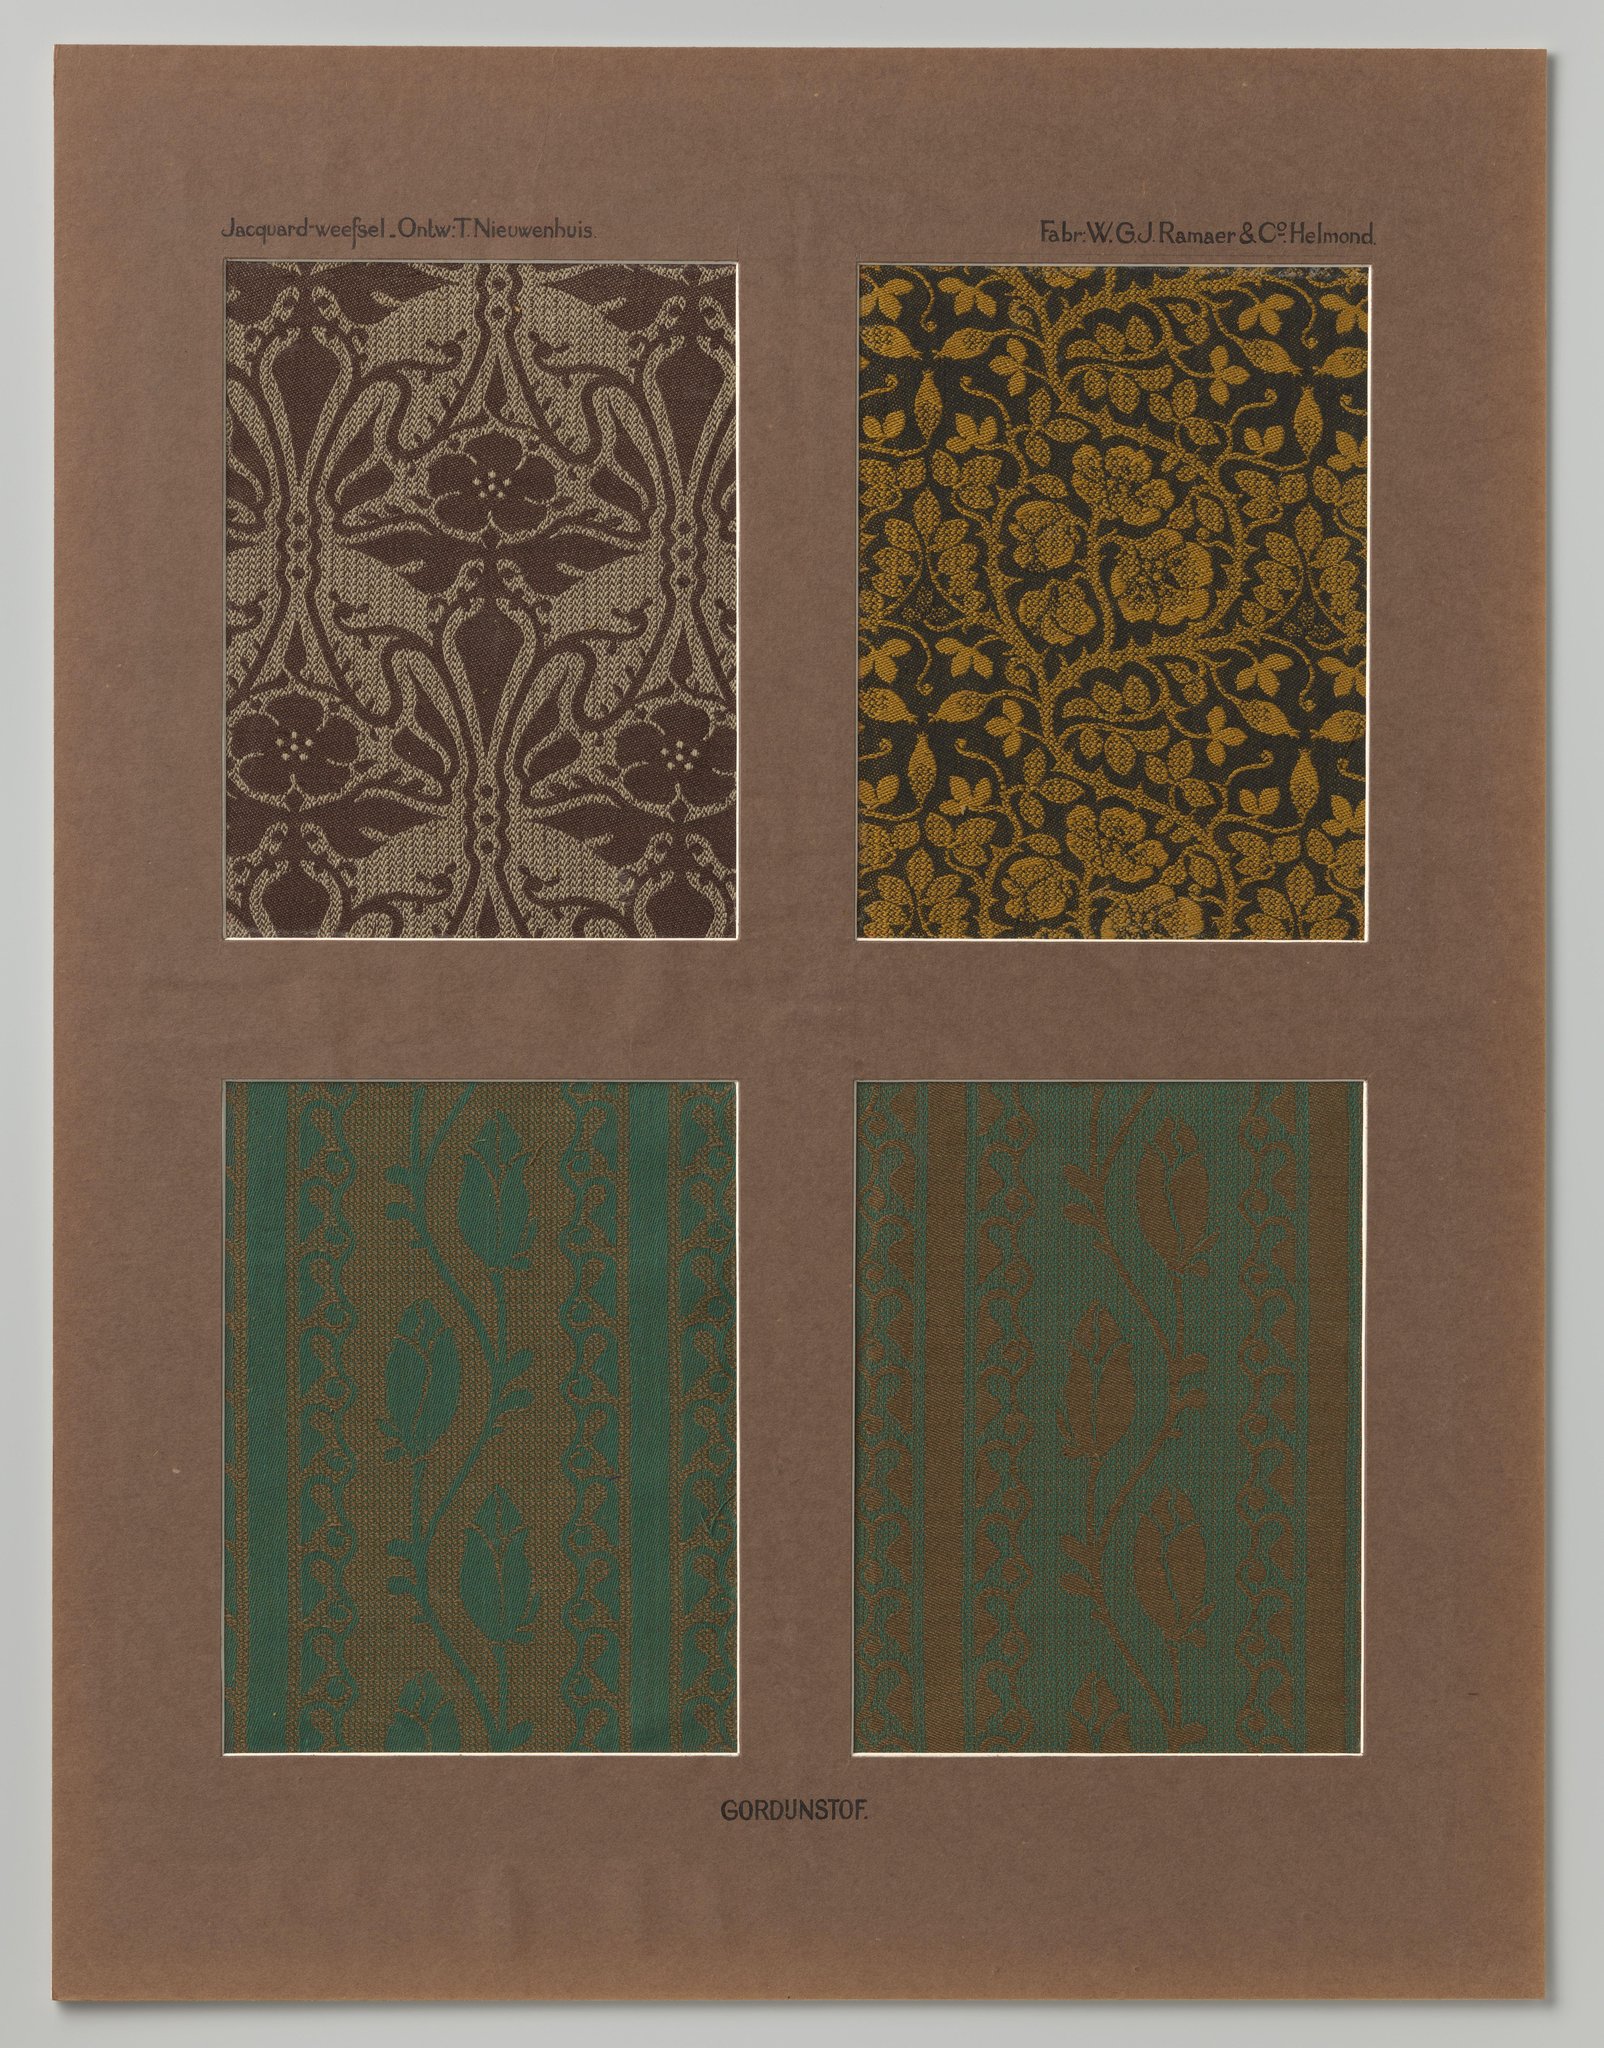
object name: sample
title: Stalen gordijnstof naar ontwerp van Theo Nieuwenhuis, in passe-partout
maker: theo nieuwenhuis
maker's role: designer, draughtsman, print maker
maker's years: 1866-1951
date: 1910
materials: cardboard, cotton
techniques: jacquard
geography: netherlands